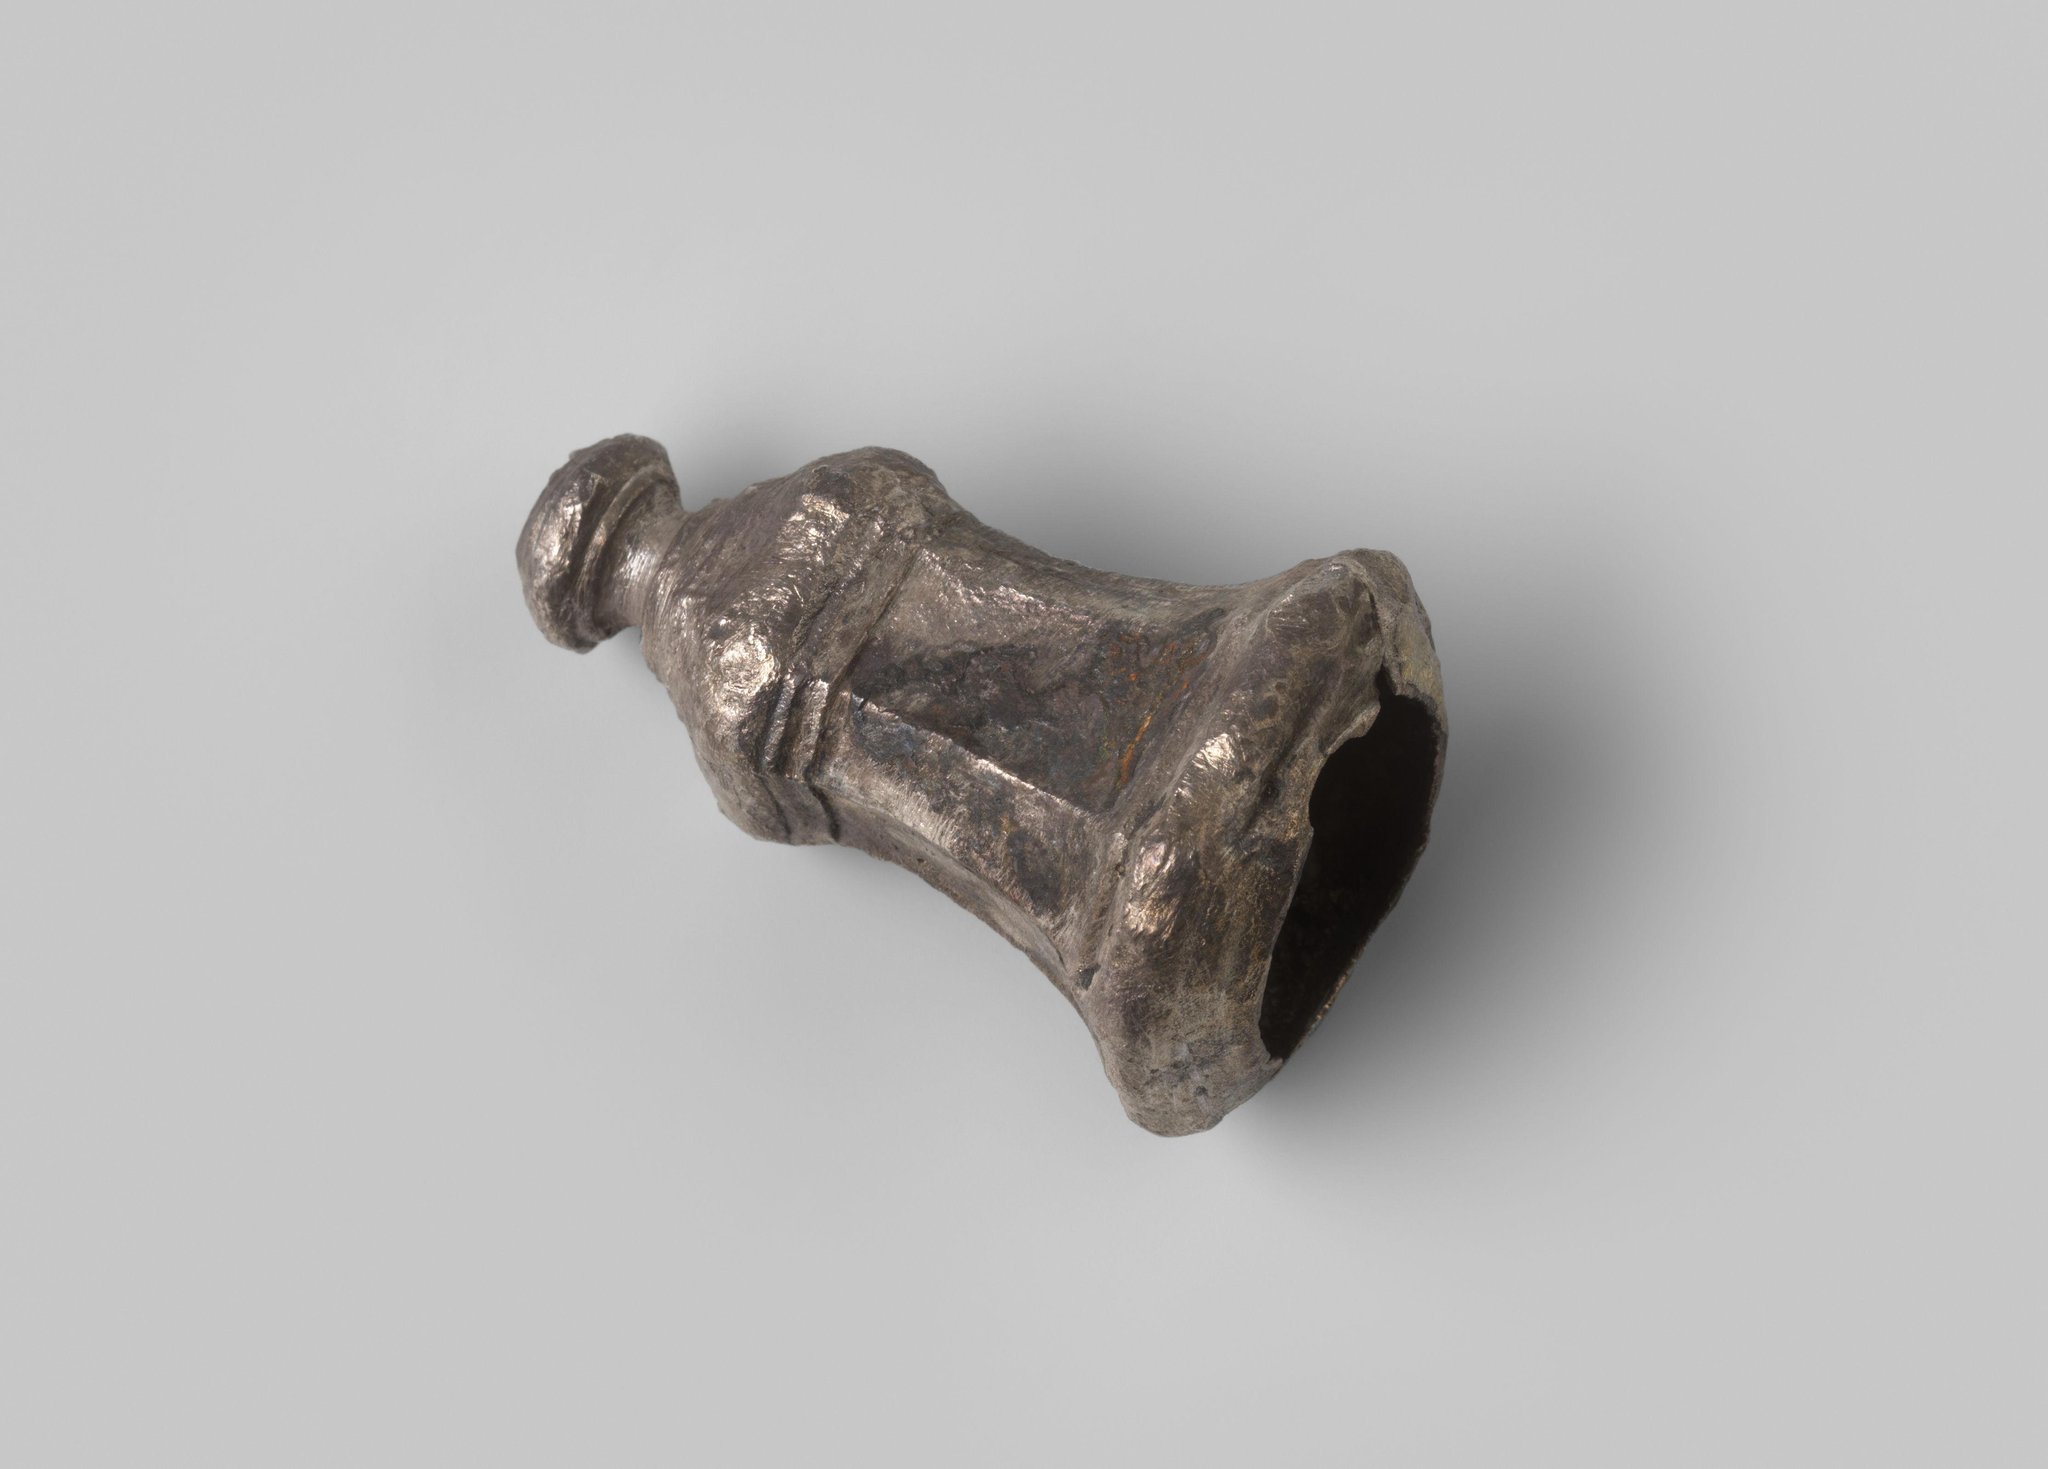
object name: candlestick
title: Steel van een kandelaar uit het wrak van de Oost-Indiëvaarder Hollandia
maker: Anonymous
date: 1700-1743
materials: silver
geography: netherlands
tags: verenigde oostindische compagnie, hollandia (schip), annet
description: Candlestick, stem; fragm, id. NG 1980-27H680.